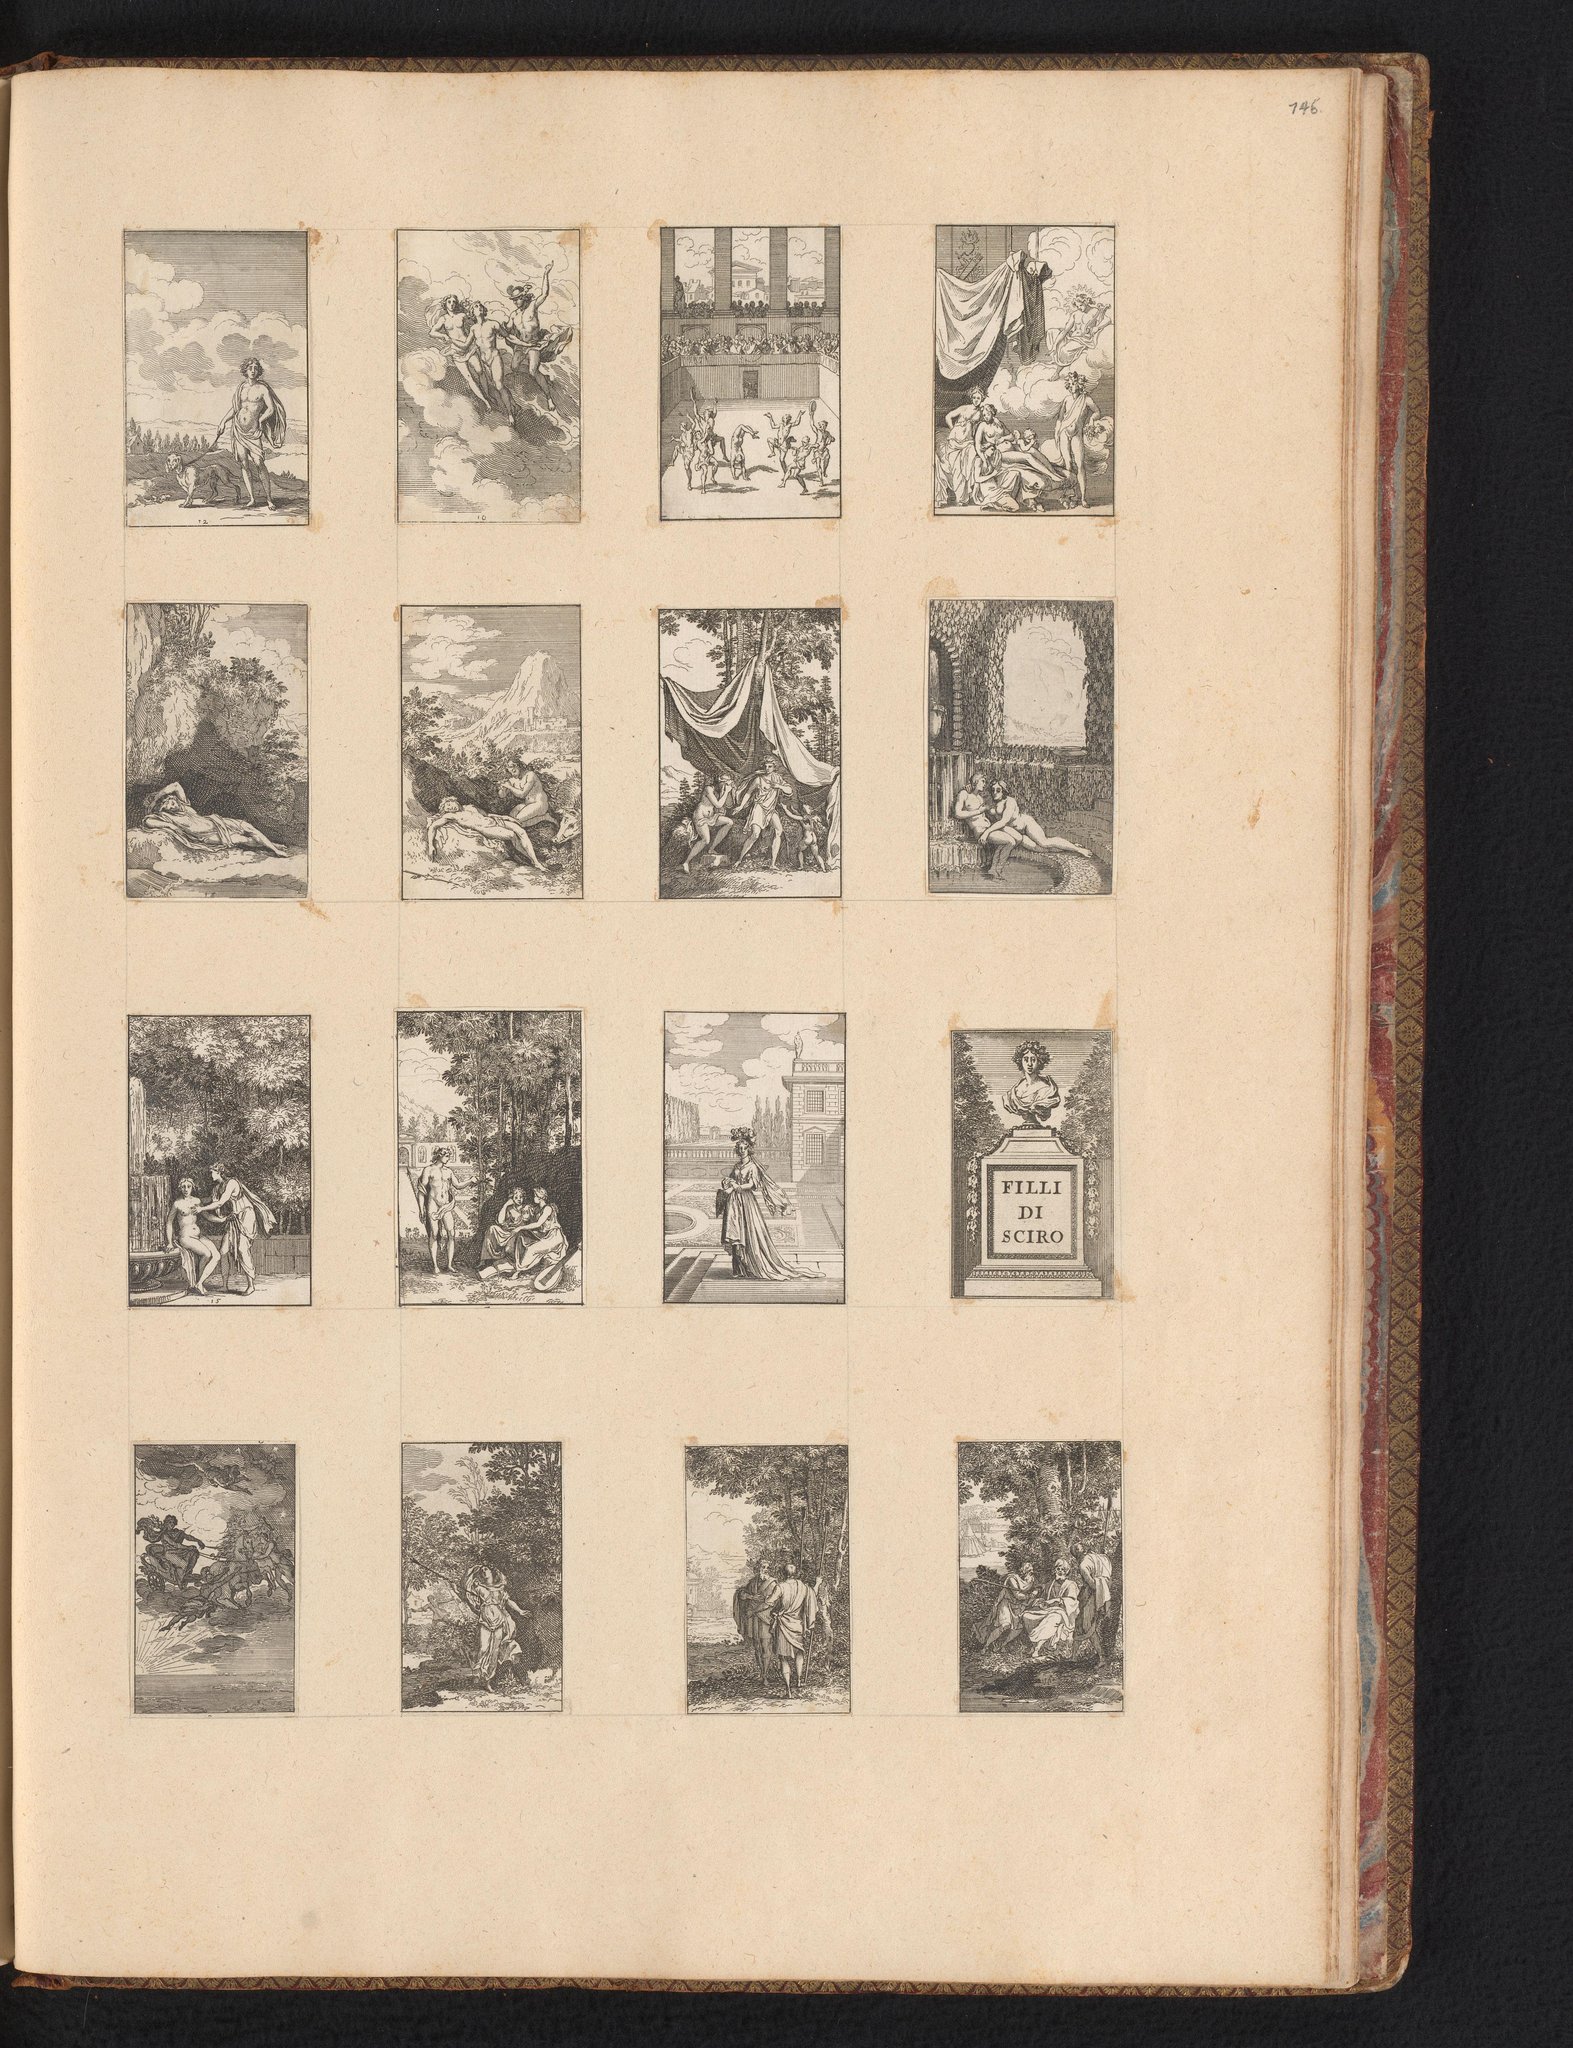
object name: book illustration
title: Elf prenten uit Marino's 'L'Adone, poeme heroico (...)' en vijf prenten uit Bonarelli della Rovere's 'Filli di Sciro (...)'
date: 1678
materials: paper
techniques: etching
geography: amsterdam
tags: (story of) adonis, pastorals, arcadian scenes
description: Deze zestien prenten maken deel uit van een album.